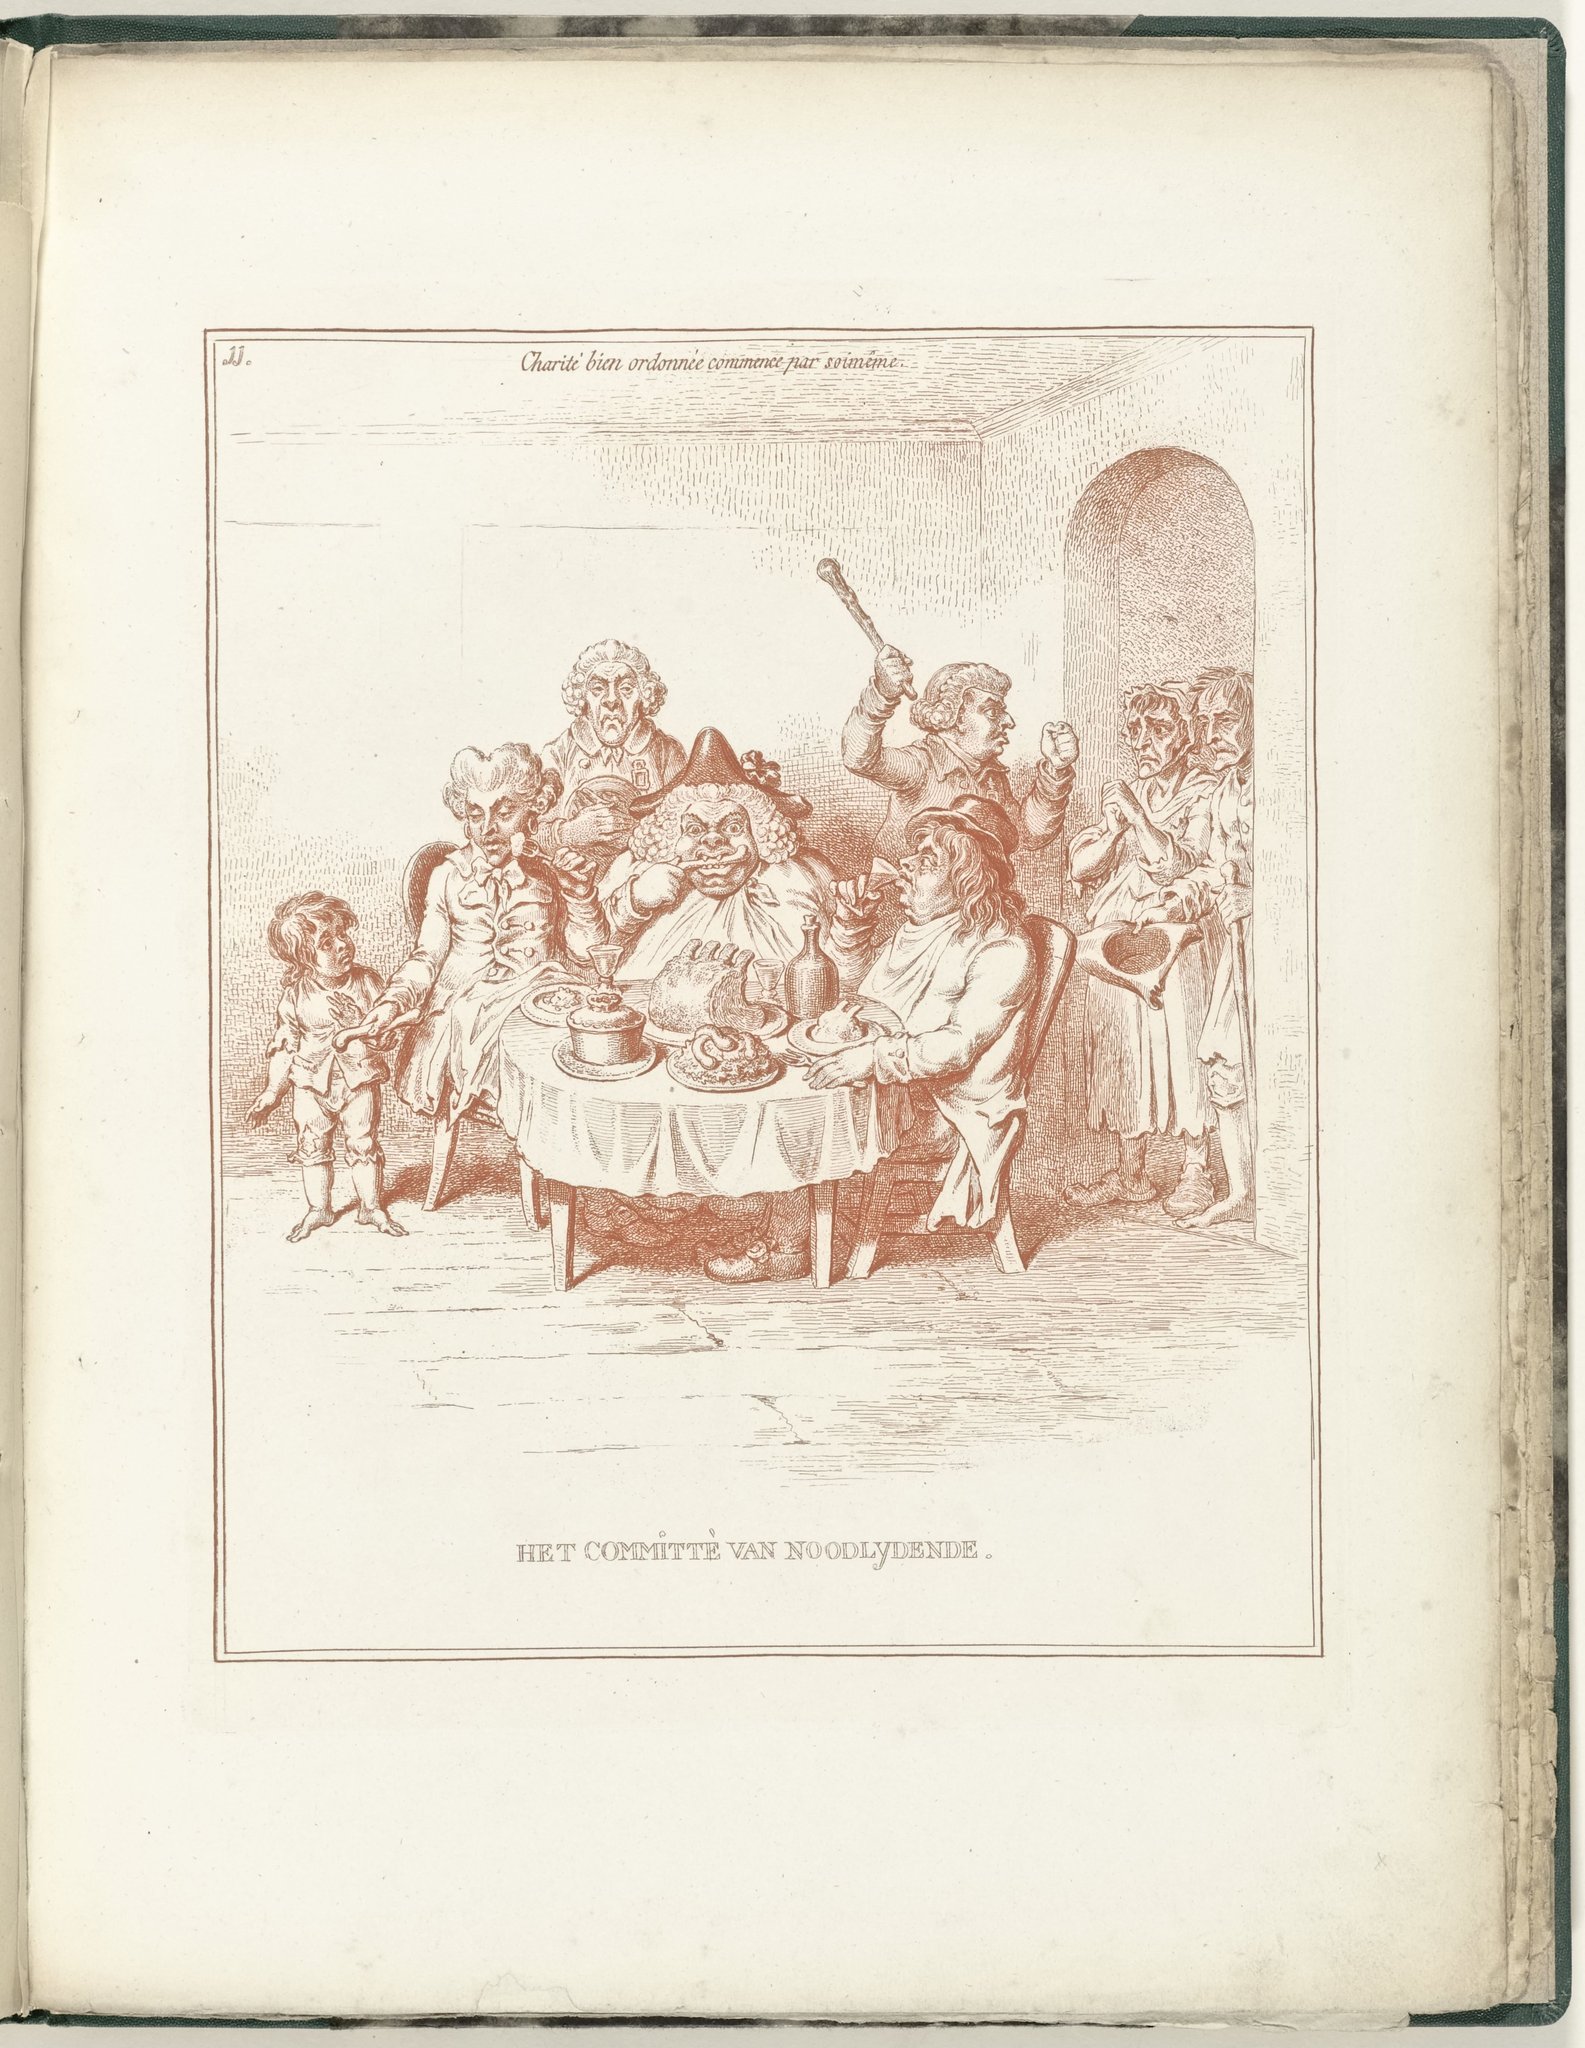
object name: print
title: Het Committé van Noodlydende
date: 1795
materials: paper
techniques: etching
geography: london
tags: celebration meal, feast, banquet, beggar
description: Onderdeel van een in boekvorm uitgegeven serie van twintig spotprenten op de Provisionele Representanten van het Volk van Holland en de Bataafse Republiek in het algemeen in het jaar 1795. De serietitel 'Hollandia Regenerata' staat vermeld op de titelprent. Elke prent gevolgd door een tekstblad met een Bijbelcitaat in het Nederlands, een verklaring in het Frans en het Bijbelcitaat in het Engels. Waarschijnlijk uitgegeven in Londen door William Humphrey in 1795.